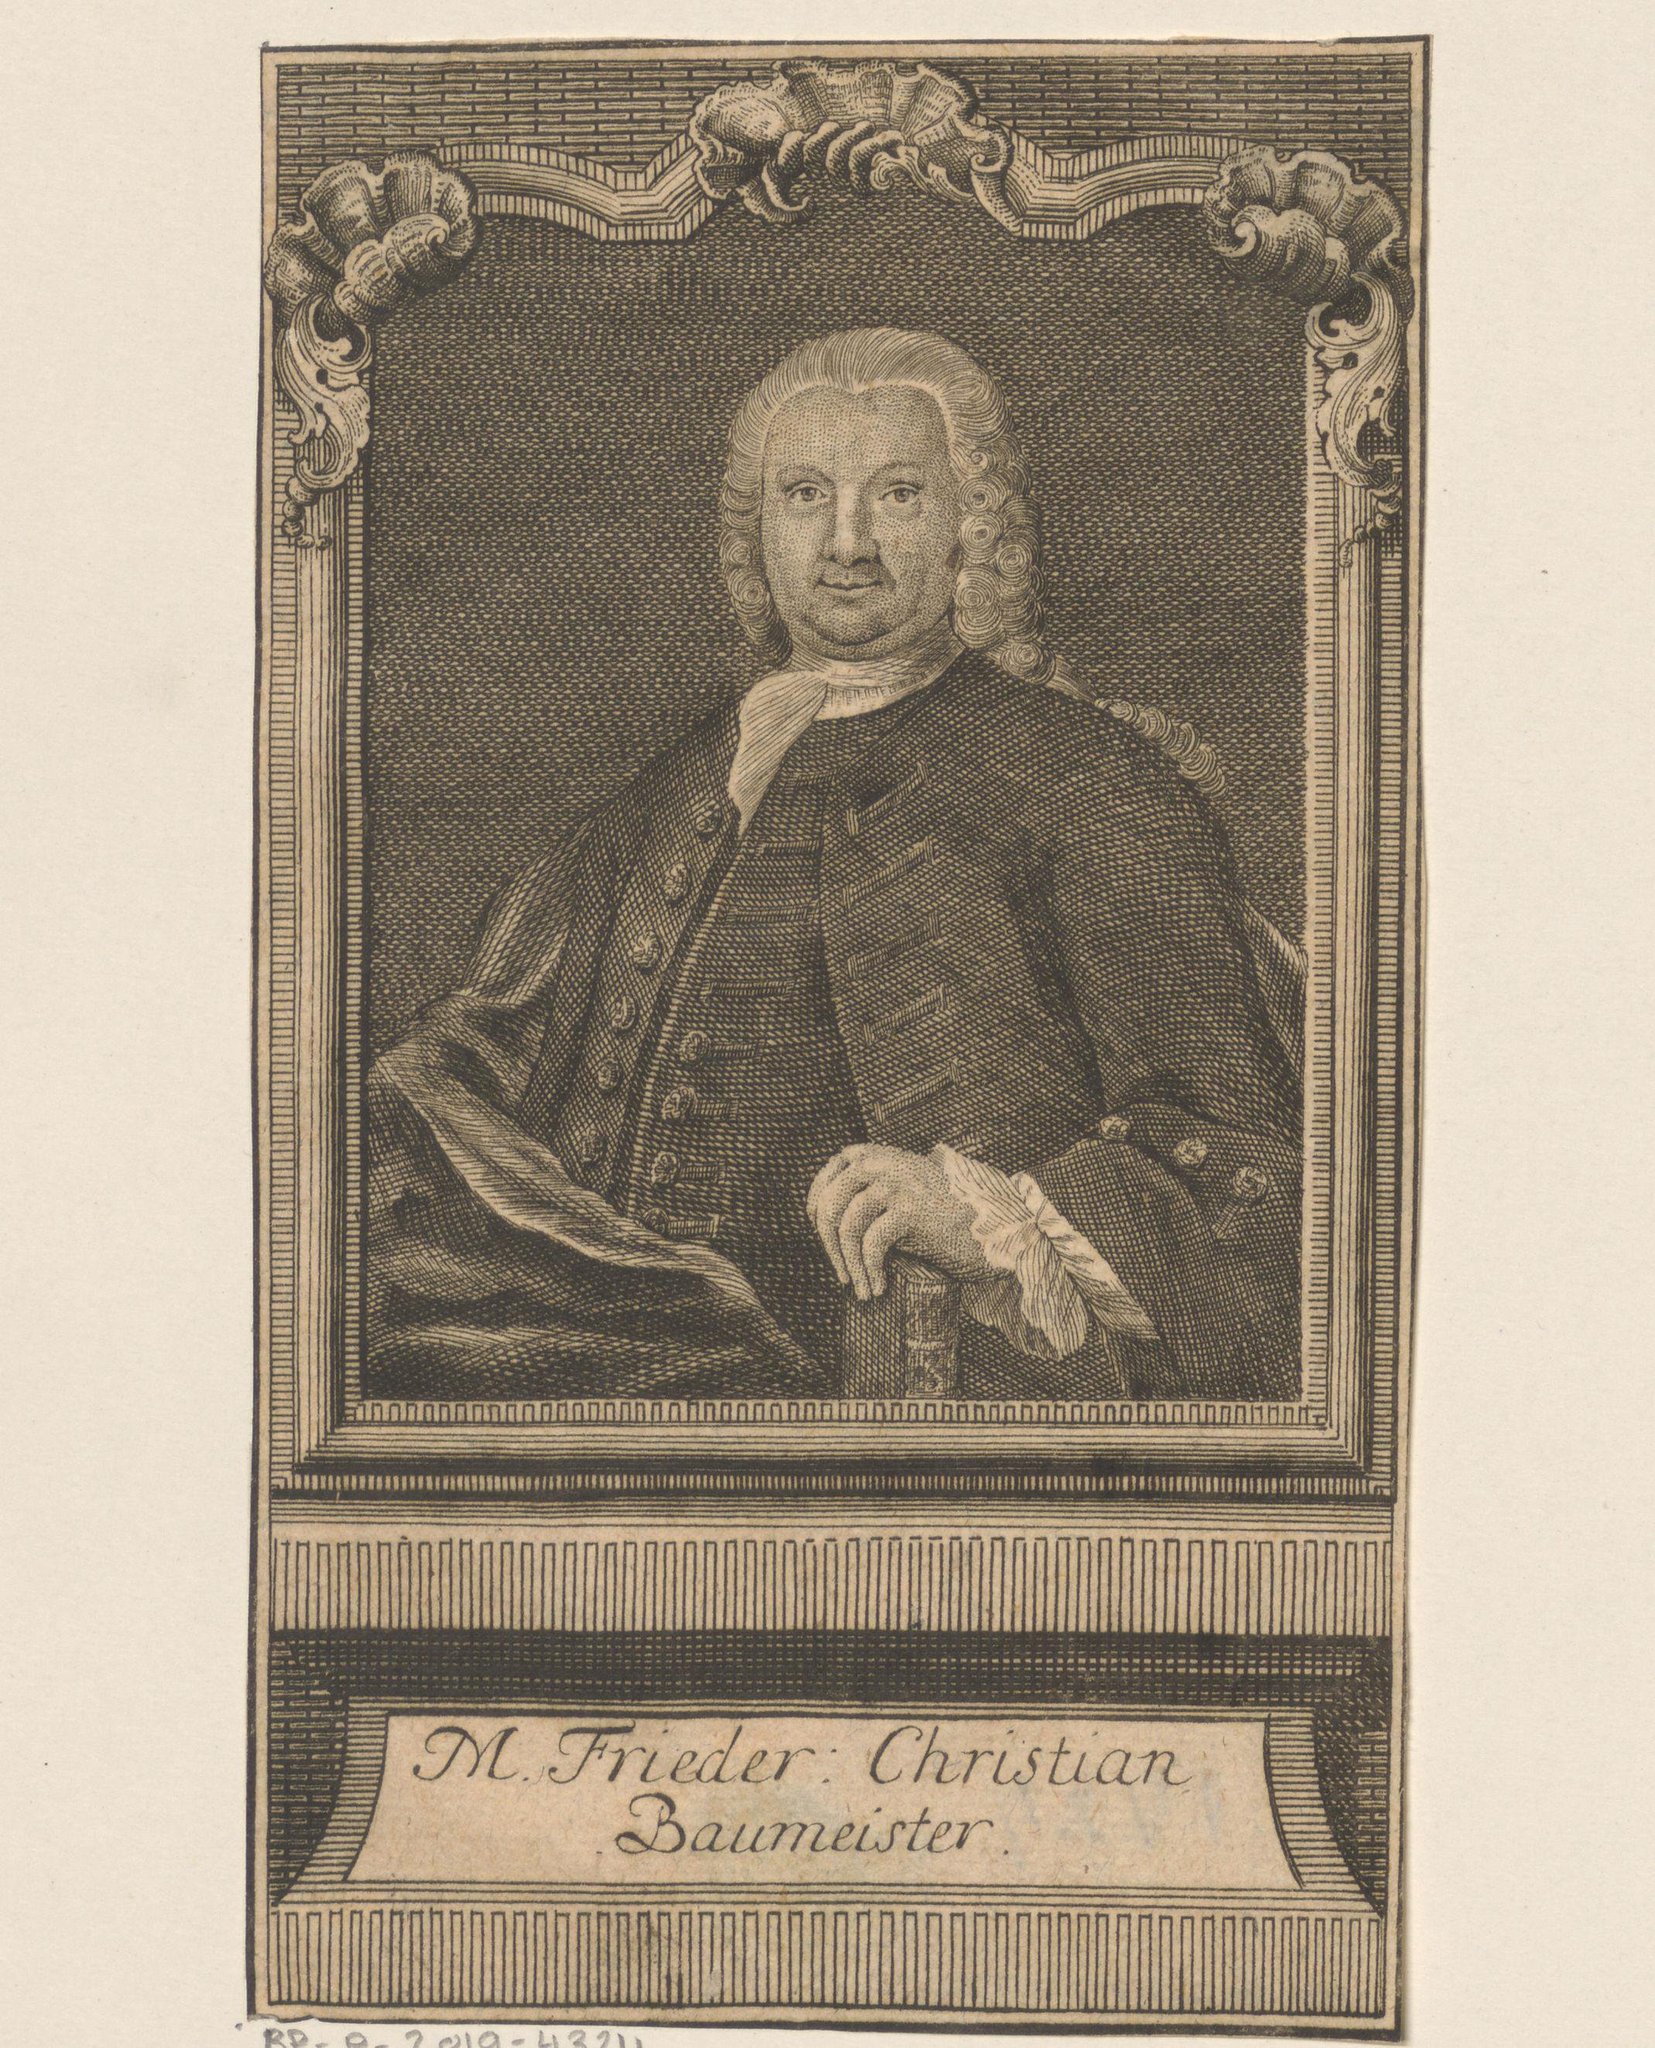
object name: print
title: Portret van Friedrich Christian Baumeister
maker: johanna dorothea sysang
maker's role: print maker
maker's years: 1729-1791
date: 1739-1791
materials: paper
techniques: engraving, etching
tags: historical persons